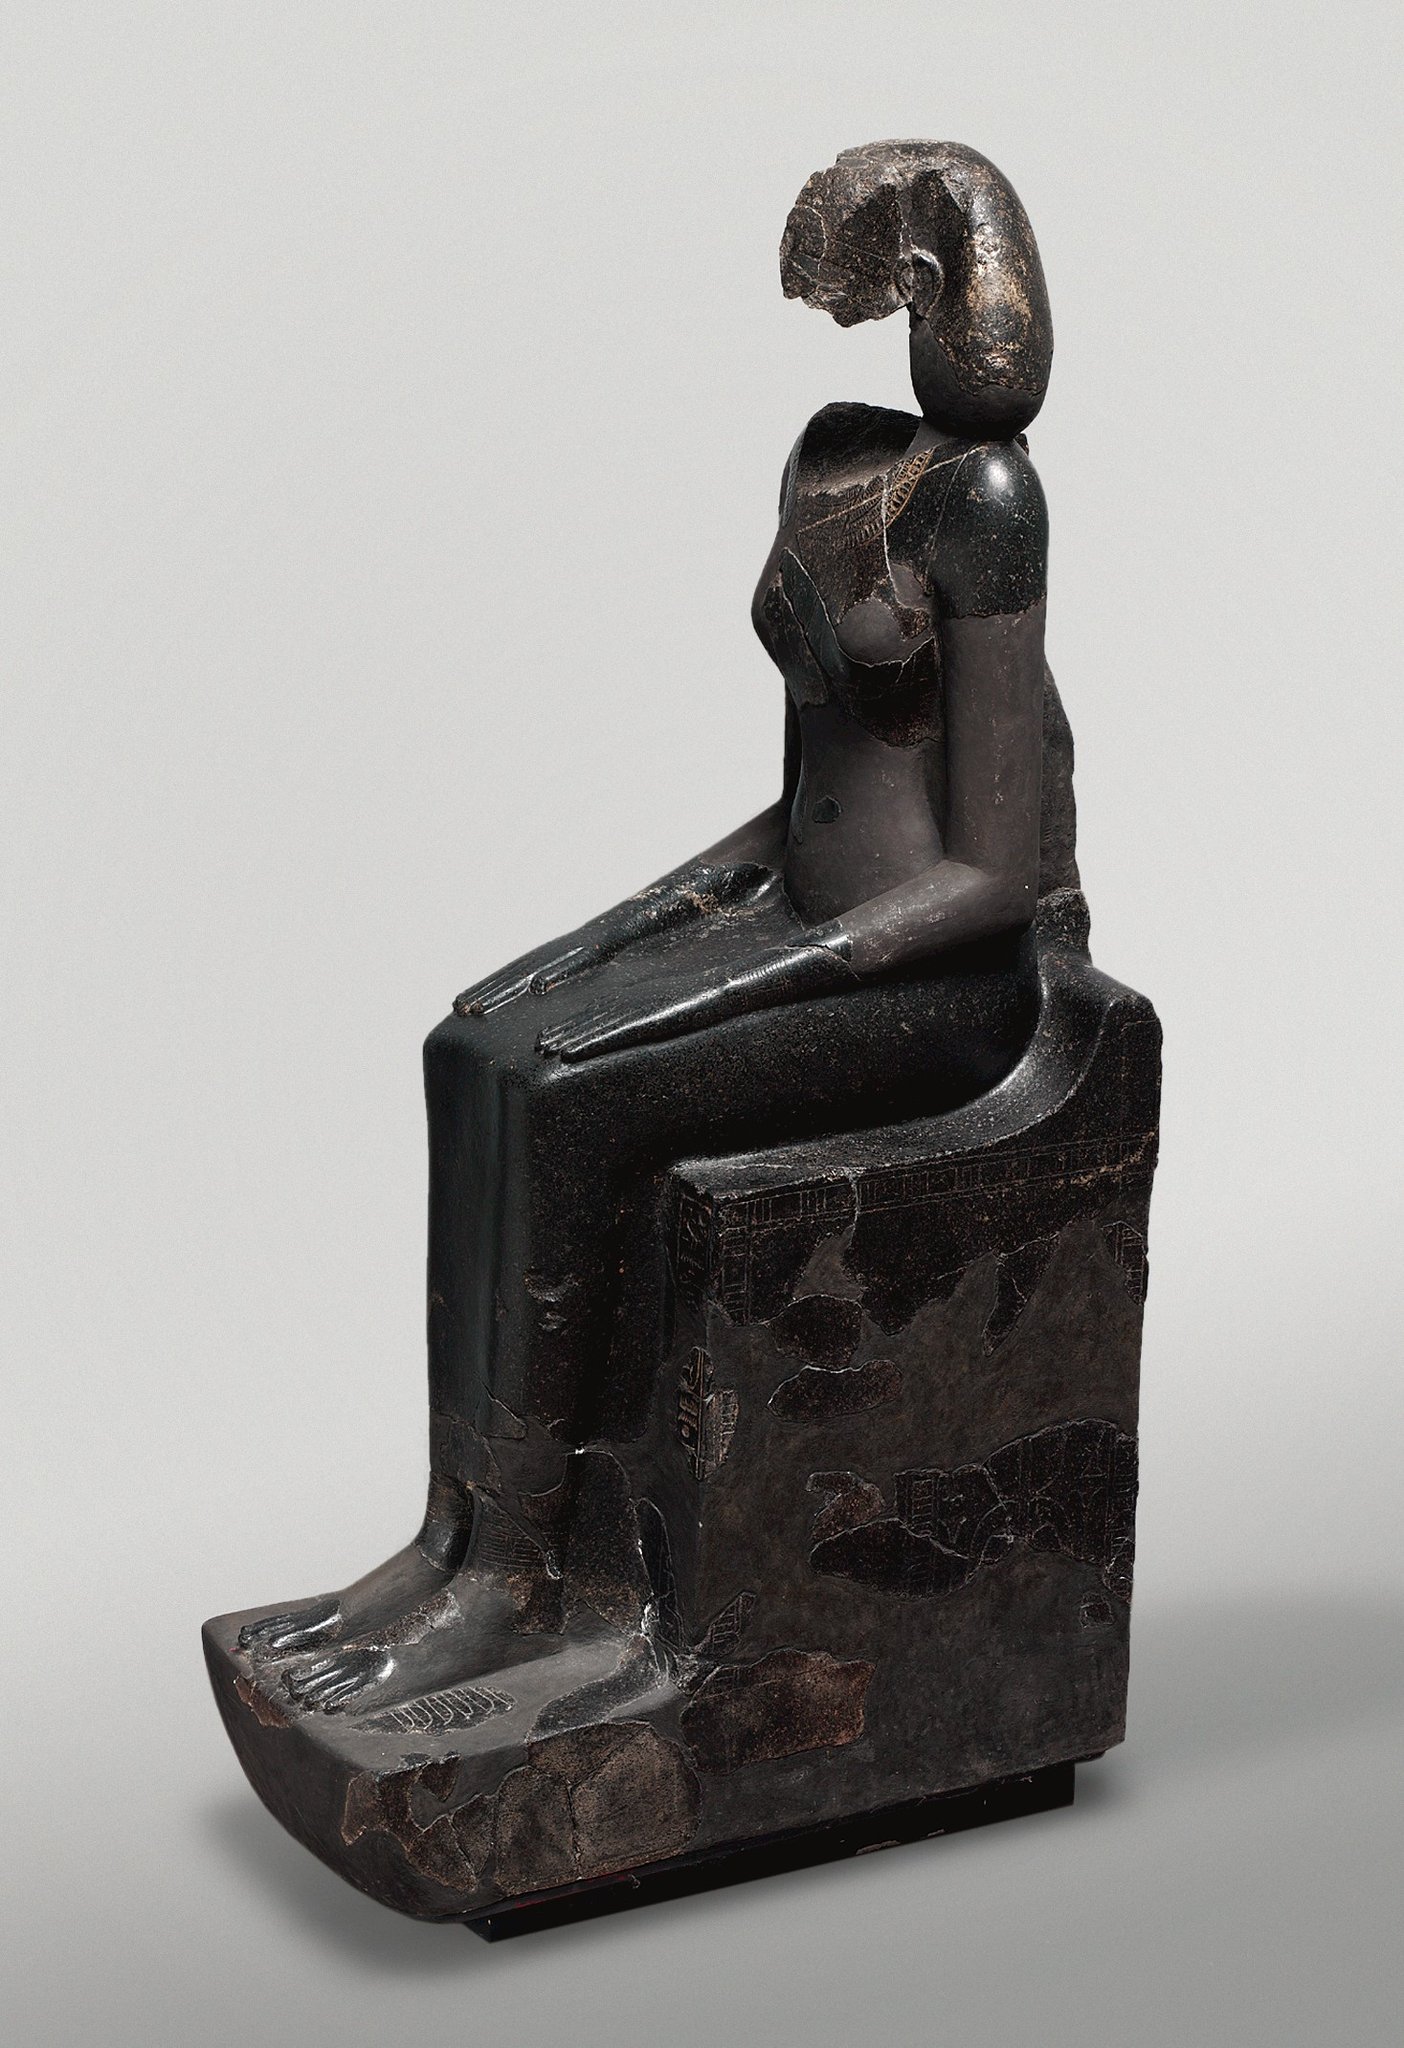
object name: statue, hatshepsut, khat headdress, amulet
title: Hatshepsut Wearing the khat Headdress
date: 1479-1458 BCE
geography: egypt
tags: women